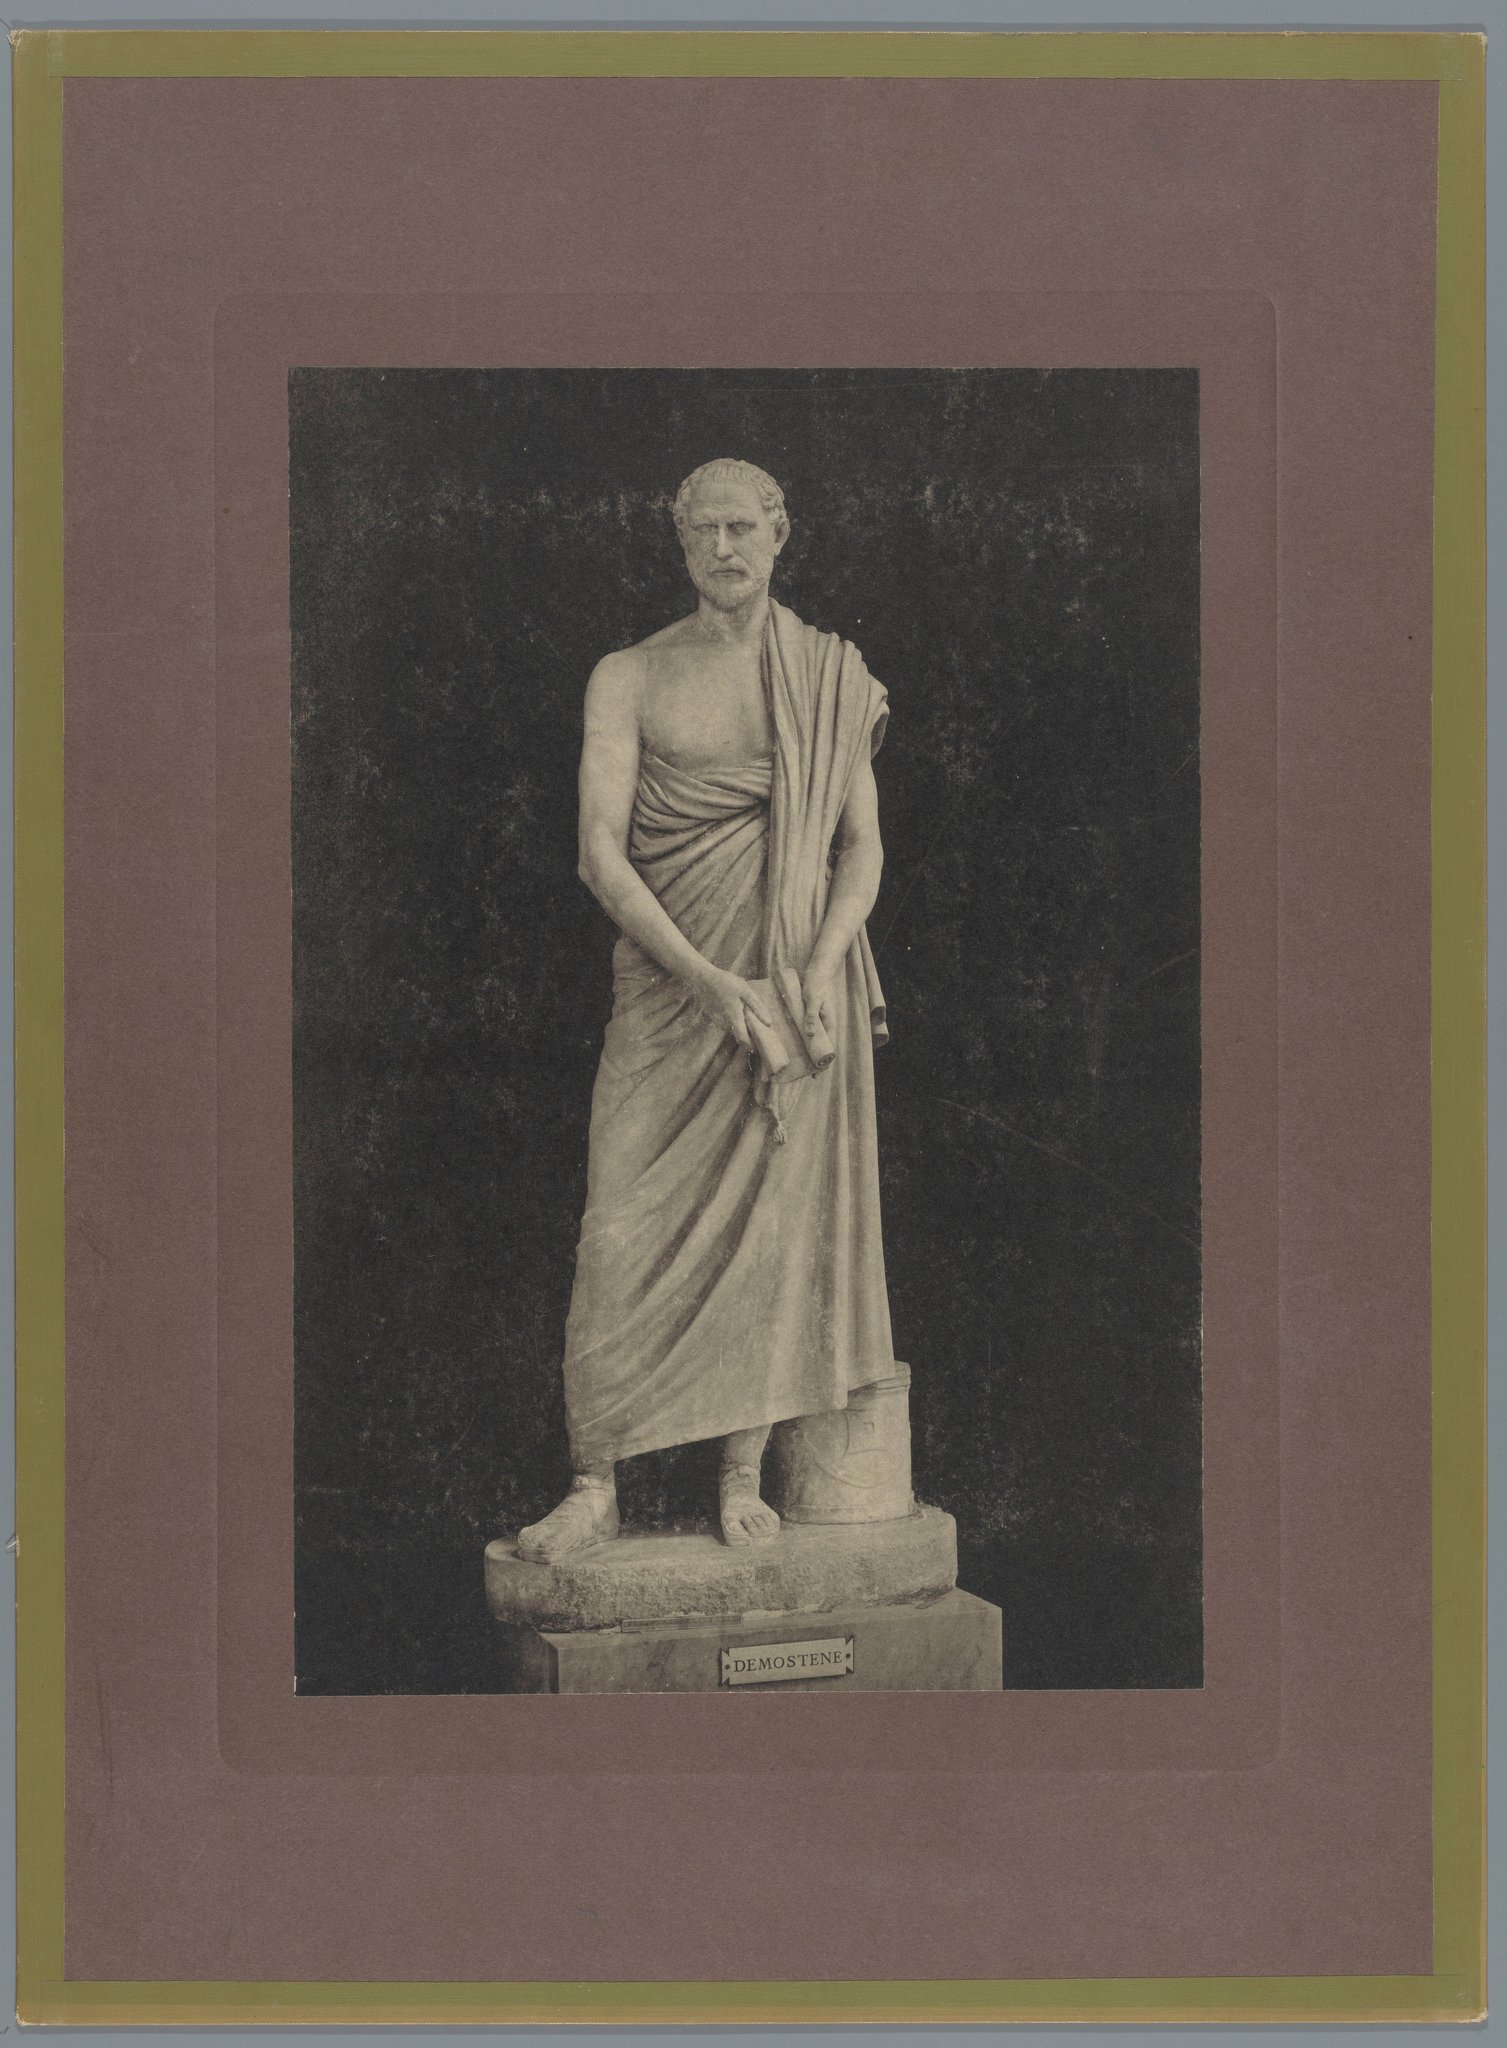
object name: photograph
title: Demosthenes.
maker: Anonymous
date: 1895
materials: cardboard, paper, ink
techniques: photograph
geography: munich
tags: piece of sculpture, reproduction of a piece of sculpture, (story of) demosthenes, europe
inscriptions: collector's mark: Lugt 3937, number: ‘No. 10.’, inscription: